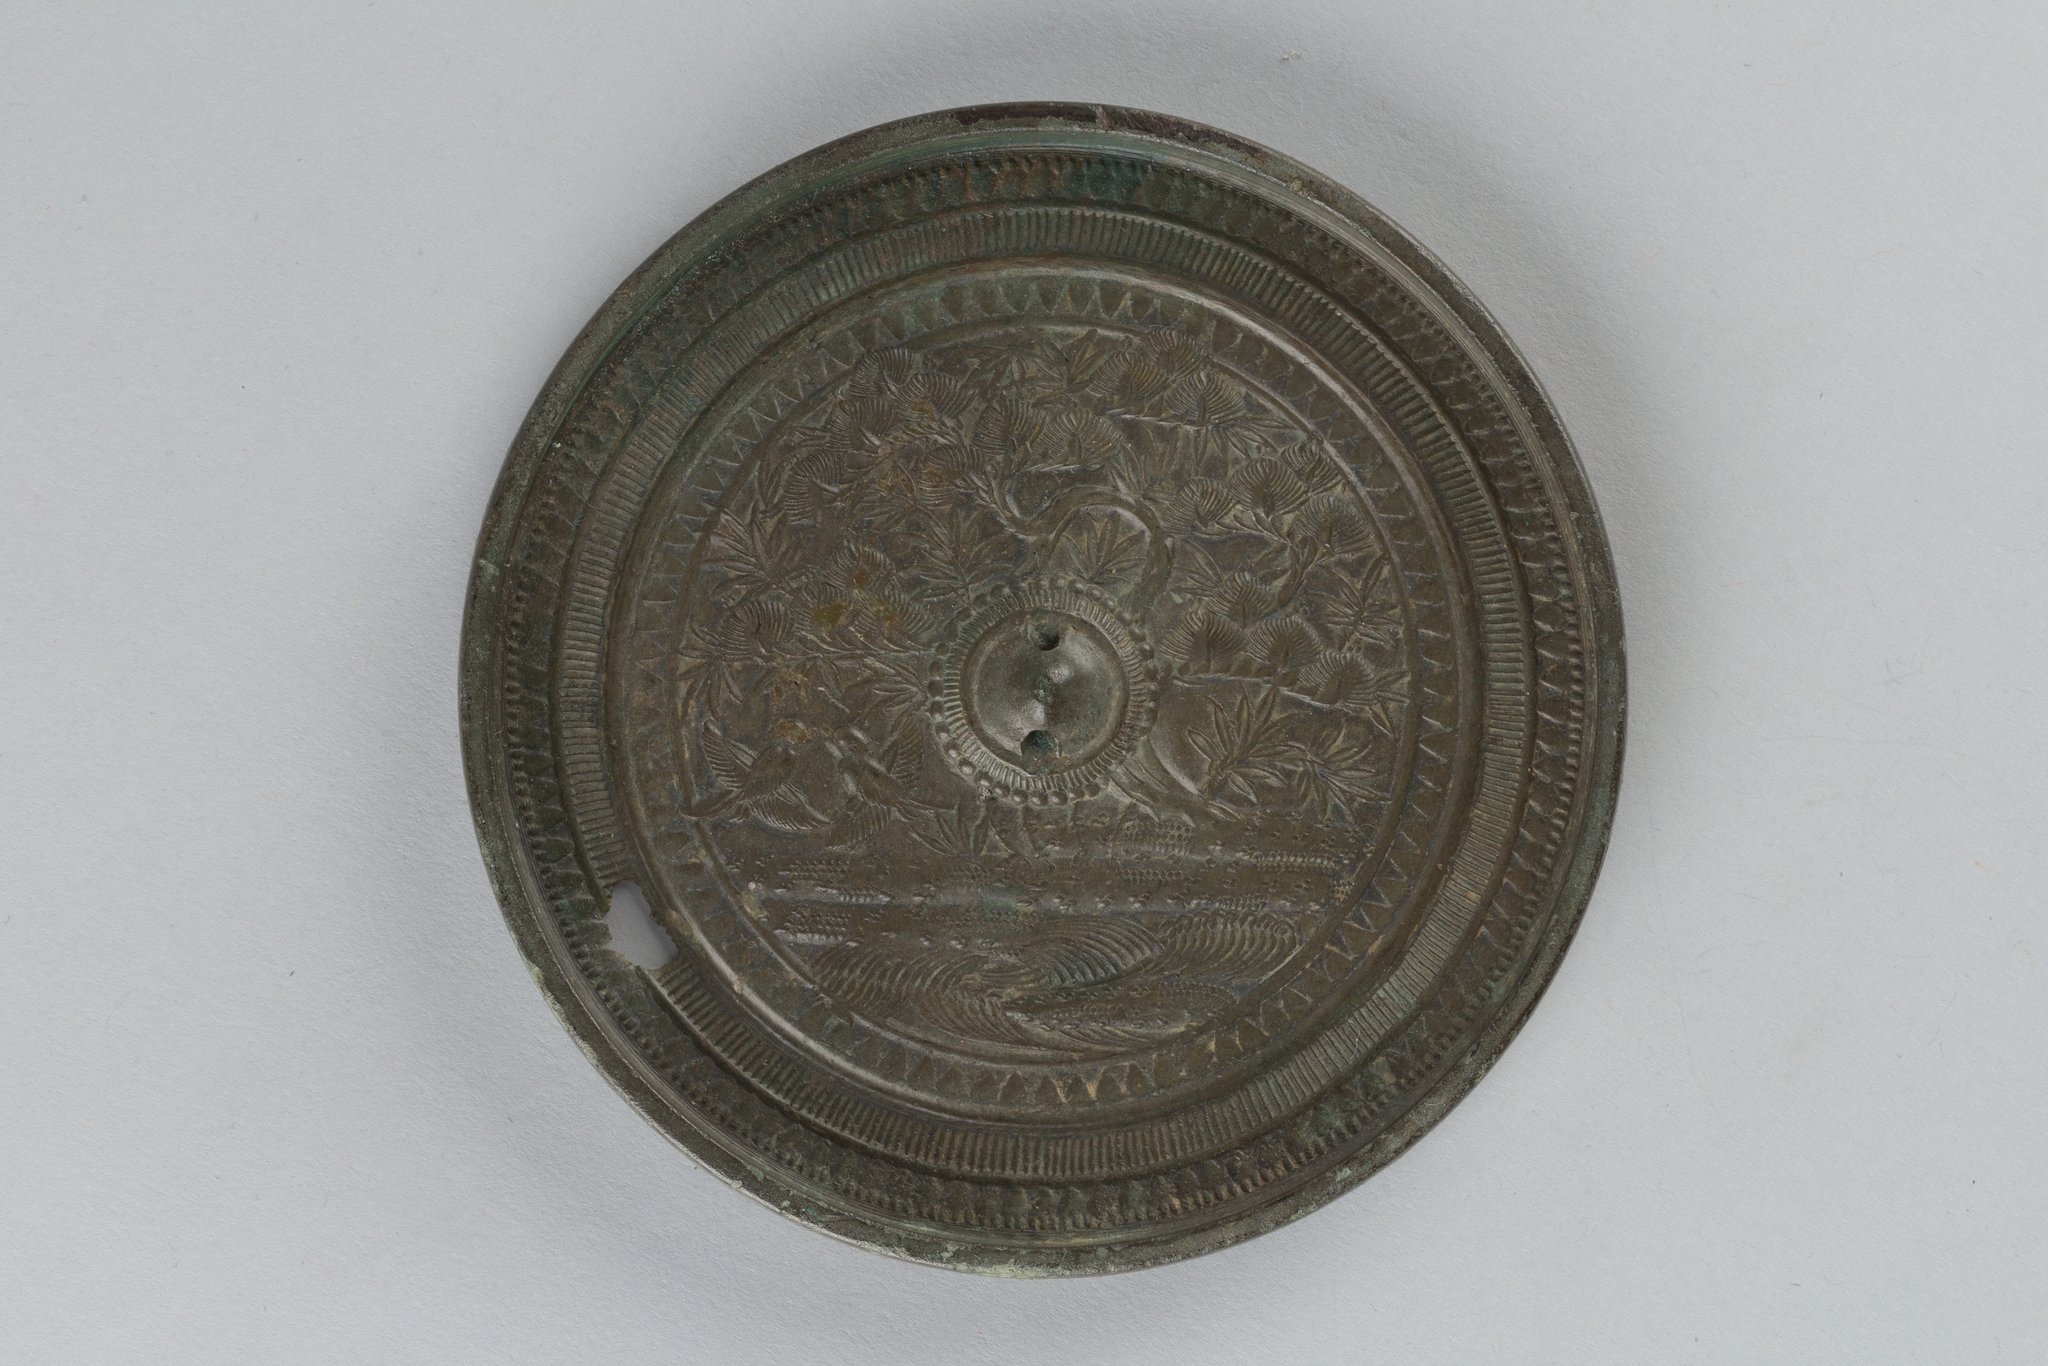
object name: mirror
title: Mirror with Decoration of Paradise of the Immortals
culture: japanese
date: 1392-1573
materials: bronze